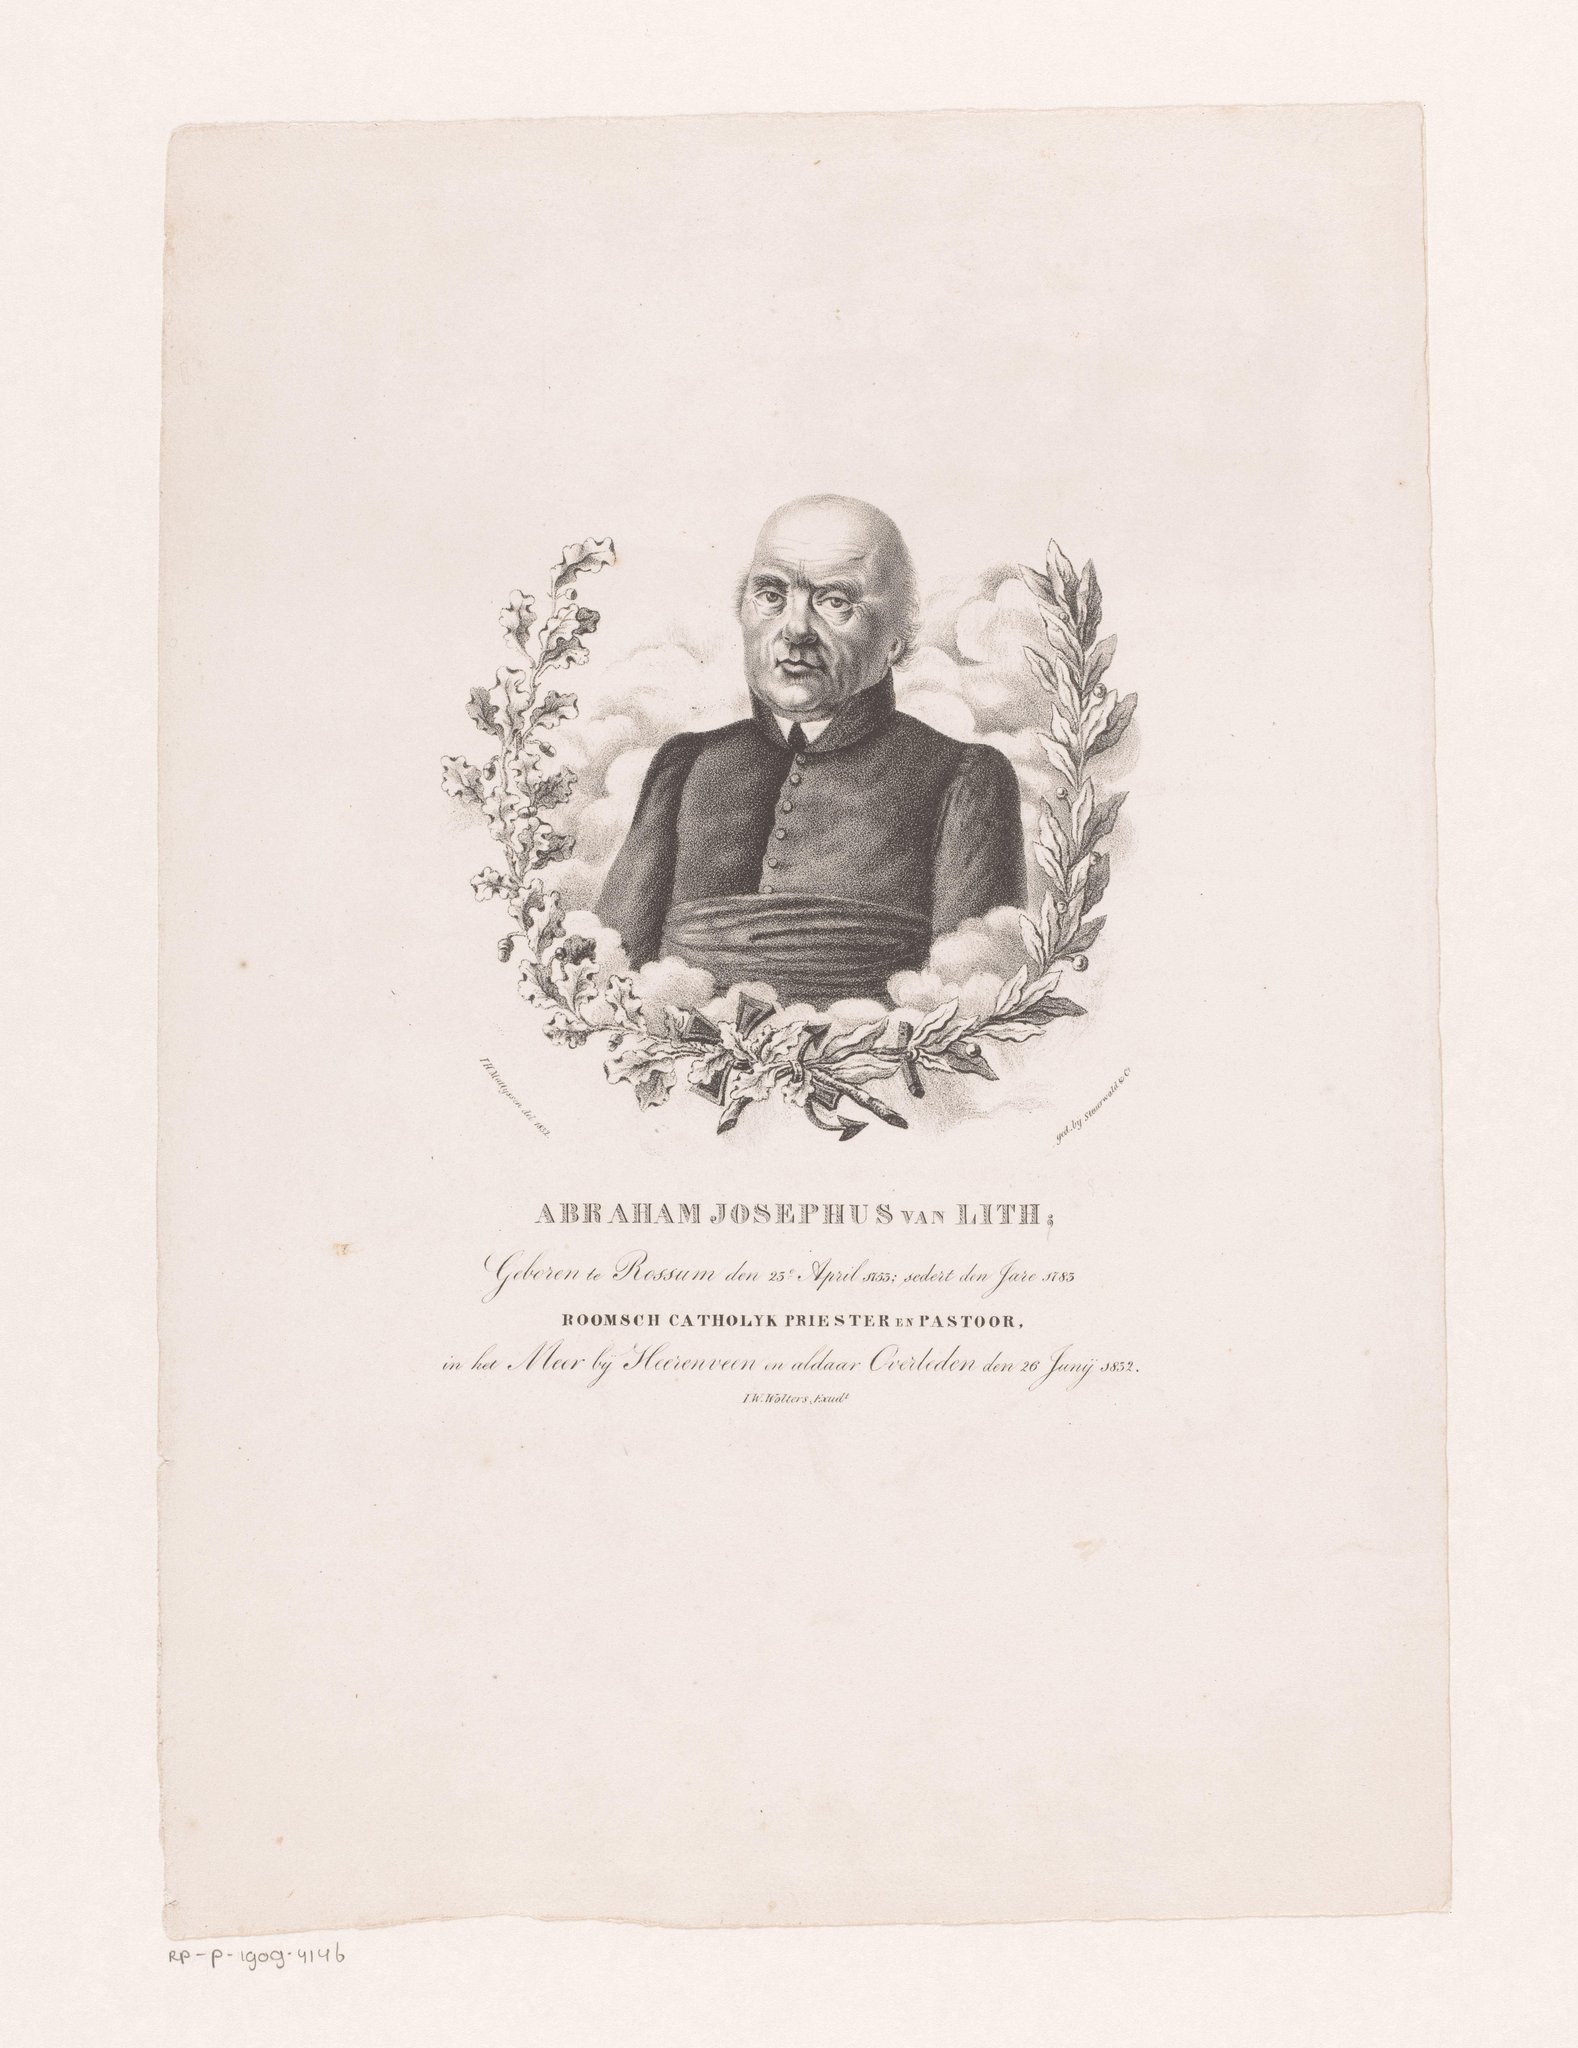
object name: print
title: Portret van Abraham Josephus van Lith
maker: j.w. wolters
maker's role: publisher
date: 1832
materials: paper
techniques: lithograph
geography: dordrecht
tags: trees: oak (+ leaf), garland, wreath, historical persons (+ (full) bust portrait)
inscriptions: collector's mark: Lugt 2228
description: De geportretteerde is afgebeeld tussen de wolken en geflankeerd door een krans van eikenbladeren en laurierbladeren, bijeengehouden door een kruis en een anker. Onder het portret een vierregelig onderschrift.